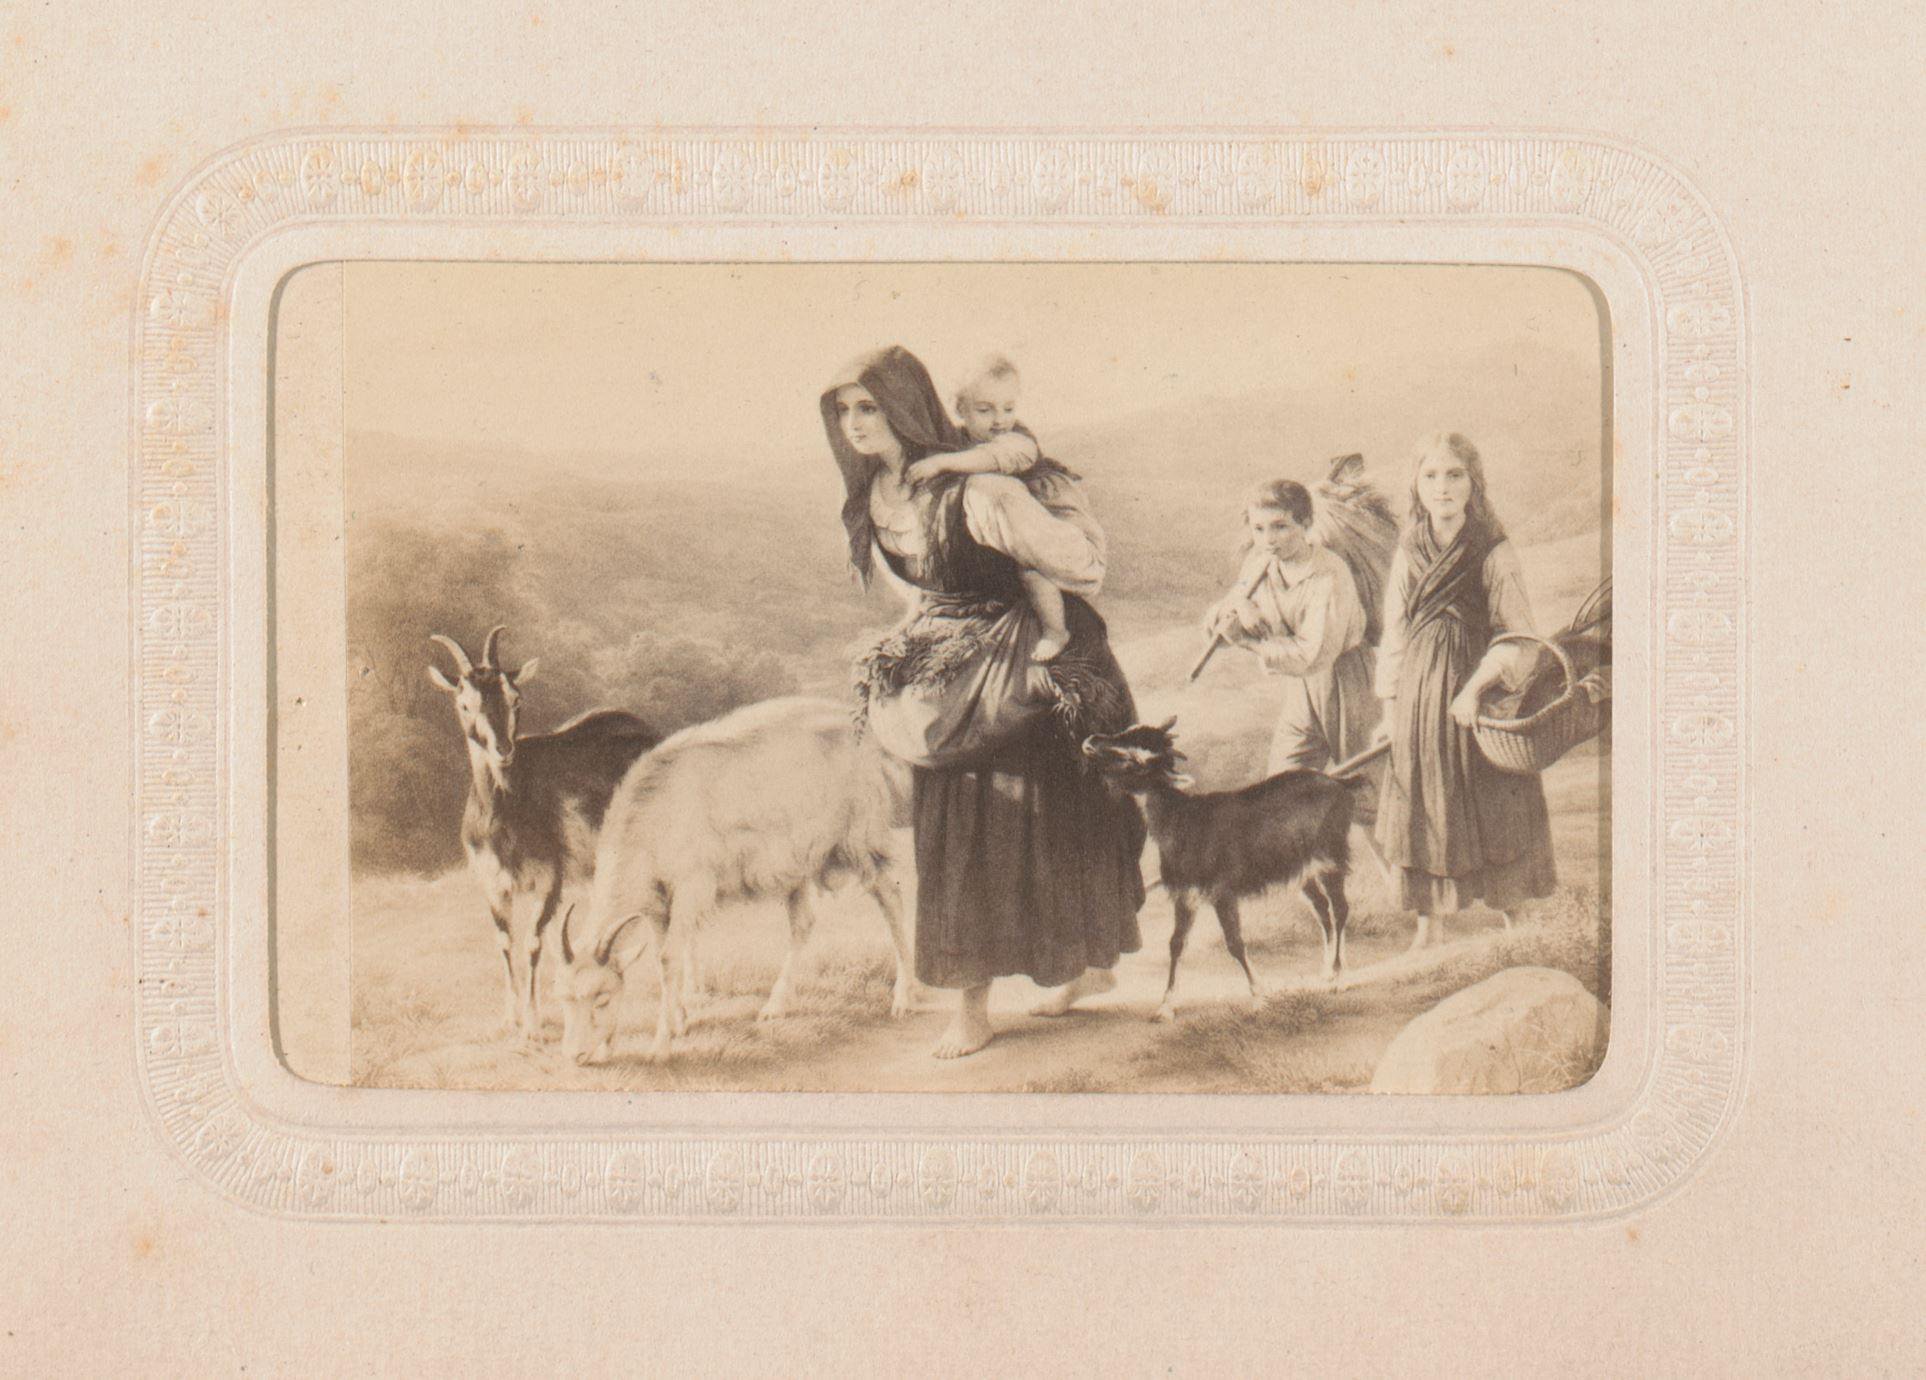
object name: carte de visite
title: Fotoreproductie van een schilderij van een reizend gezin met drie geiten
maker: Anonymous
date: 1855-1865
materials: cardboard, photographic support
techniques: albumen print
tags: goat, 'en route', traveller under way, mother and child(ren), woman and child(ren) (family group)